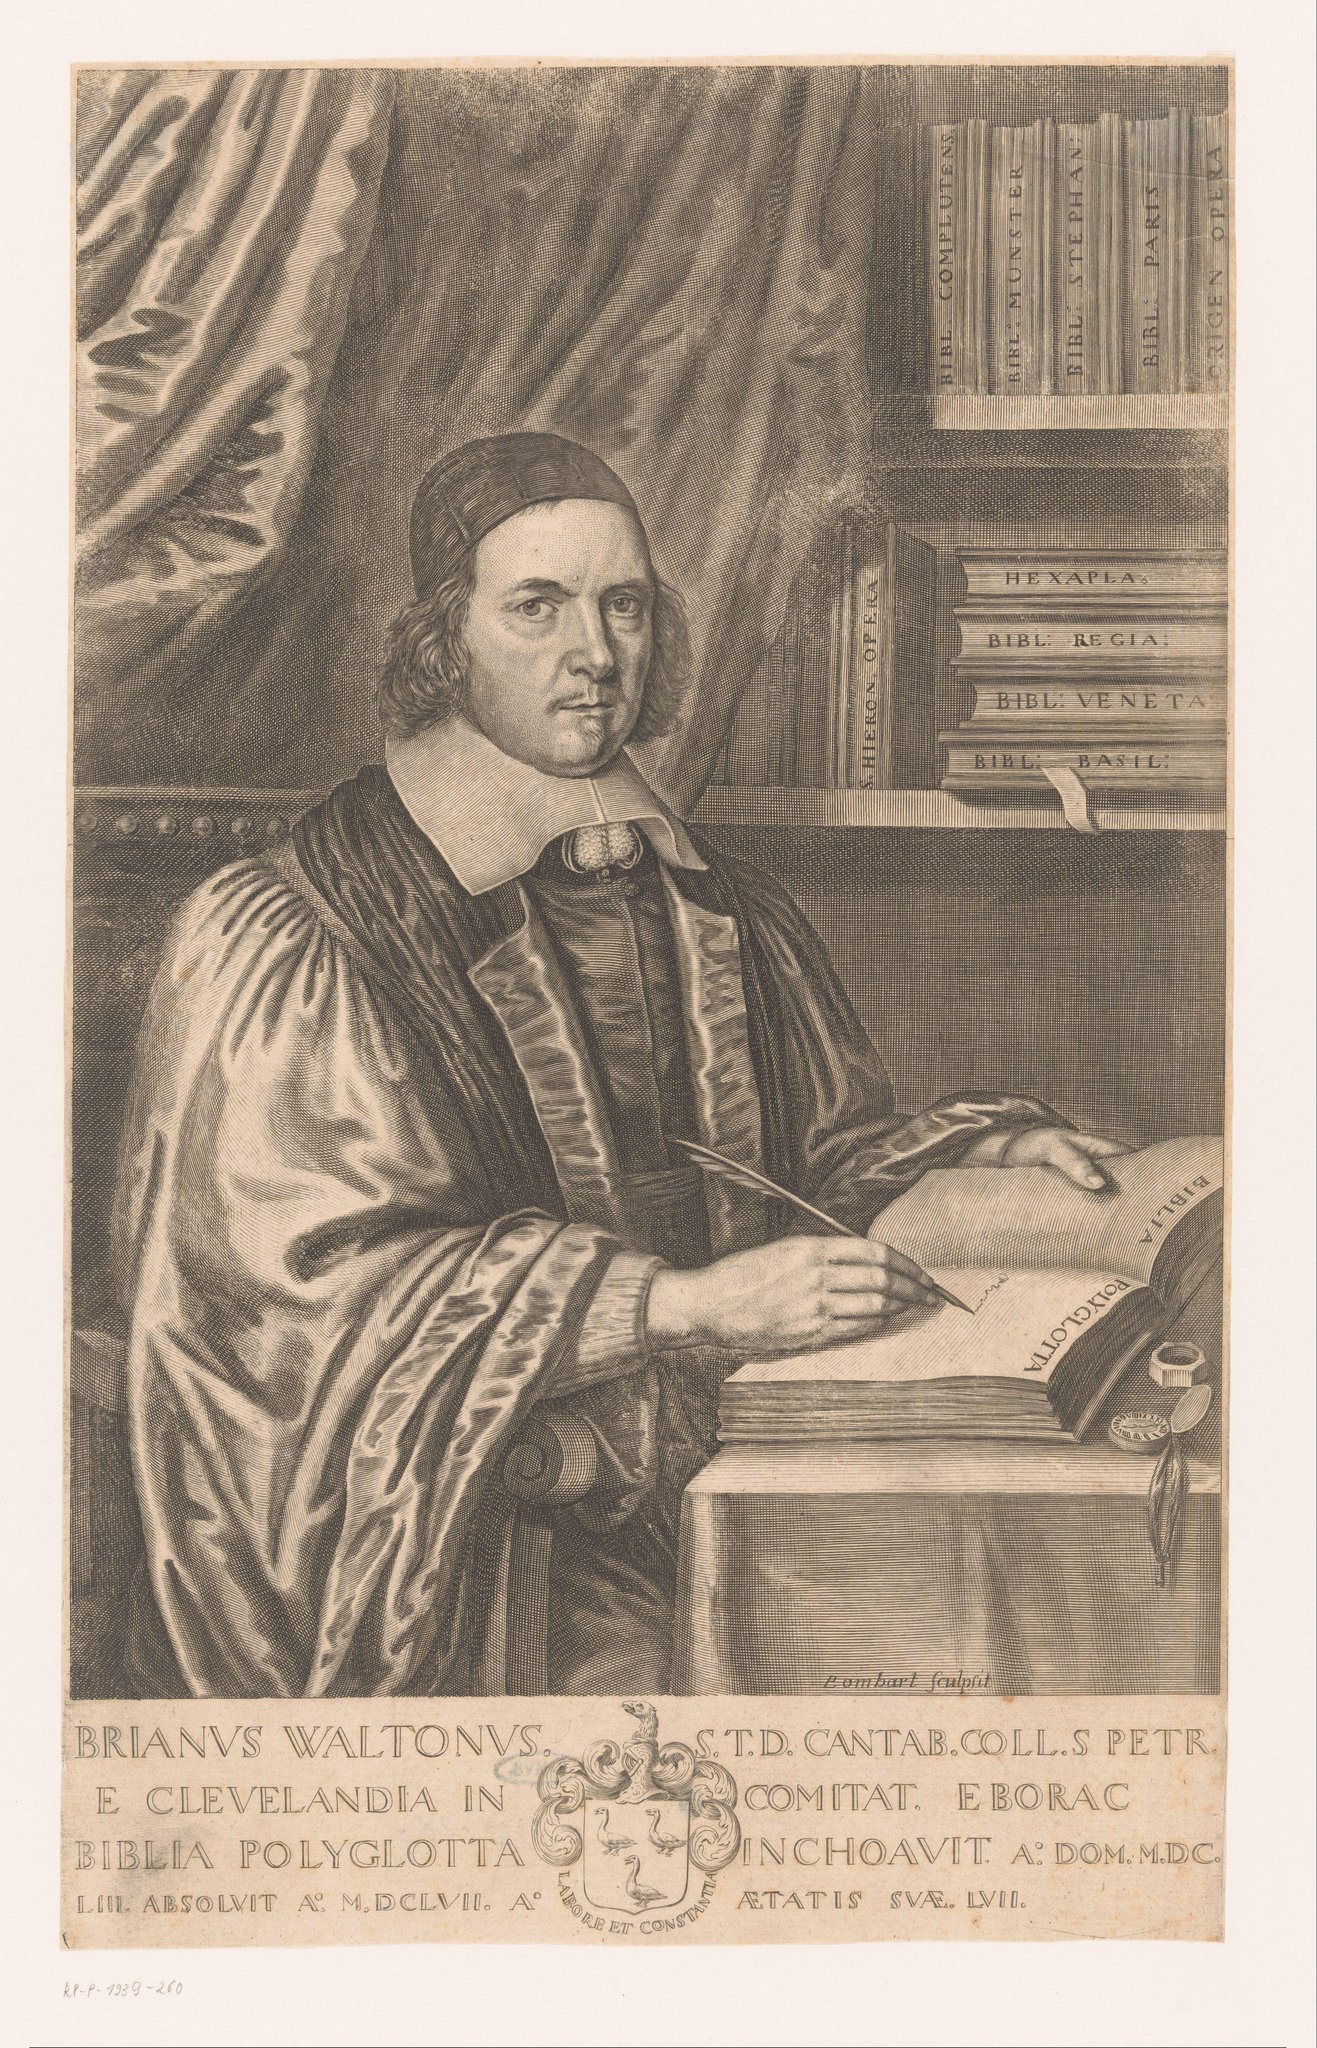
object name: print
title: Portret van Brian Walton op 57-jarige leeftijd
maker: pierre lombard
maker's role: draughtsman, print maker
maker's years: 1612-1682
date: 1657-1683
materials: paper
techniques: engraving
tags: priest, scholar in his study, historical persons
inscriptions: collector's mark: Lugt 2228, collector's mark: Lugt 2760